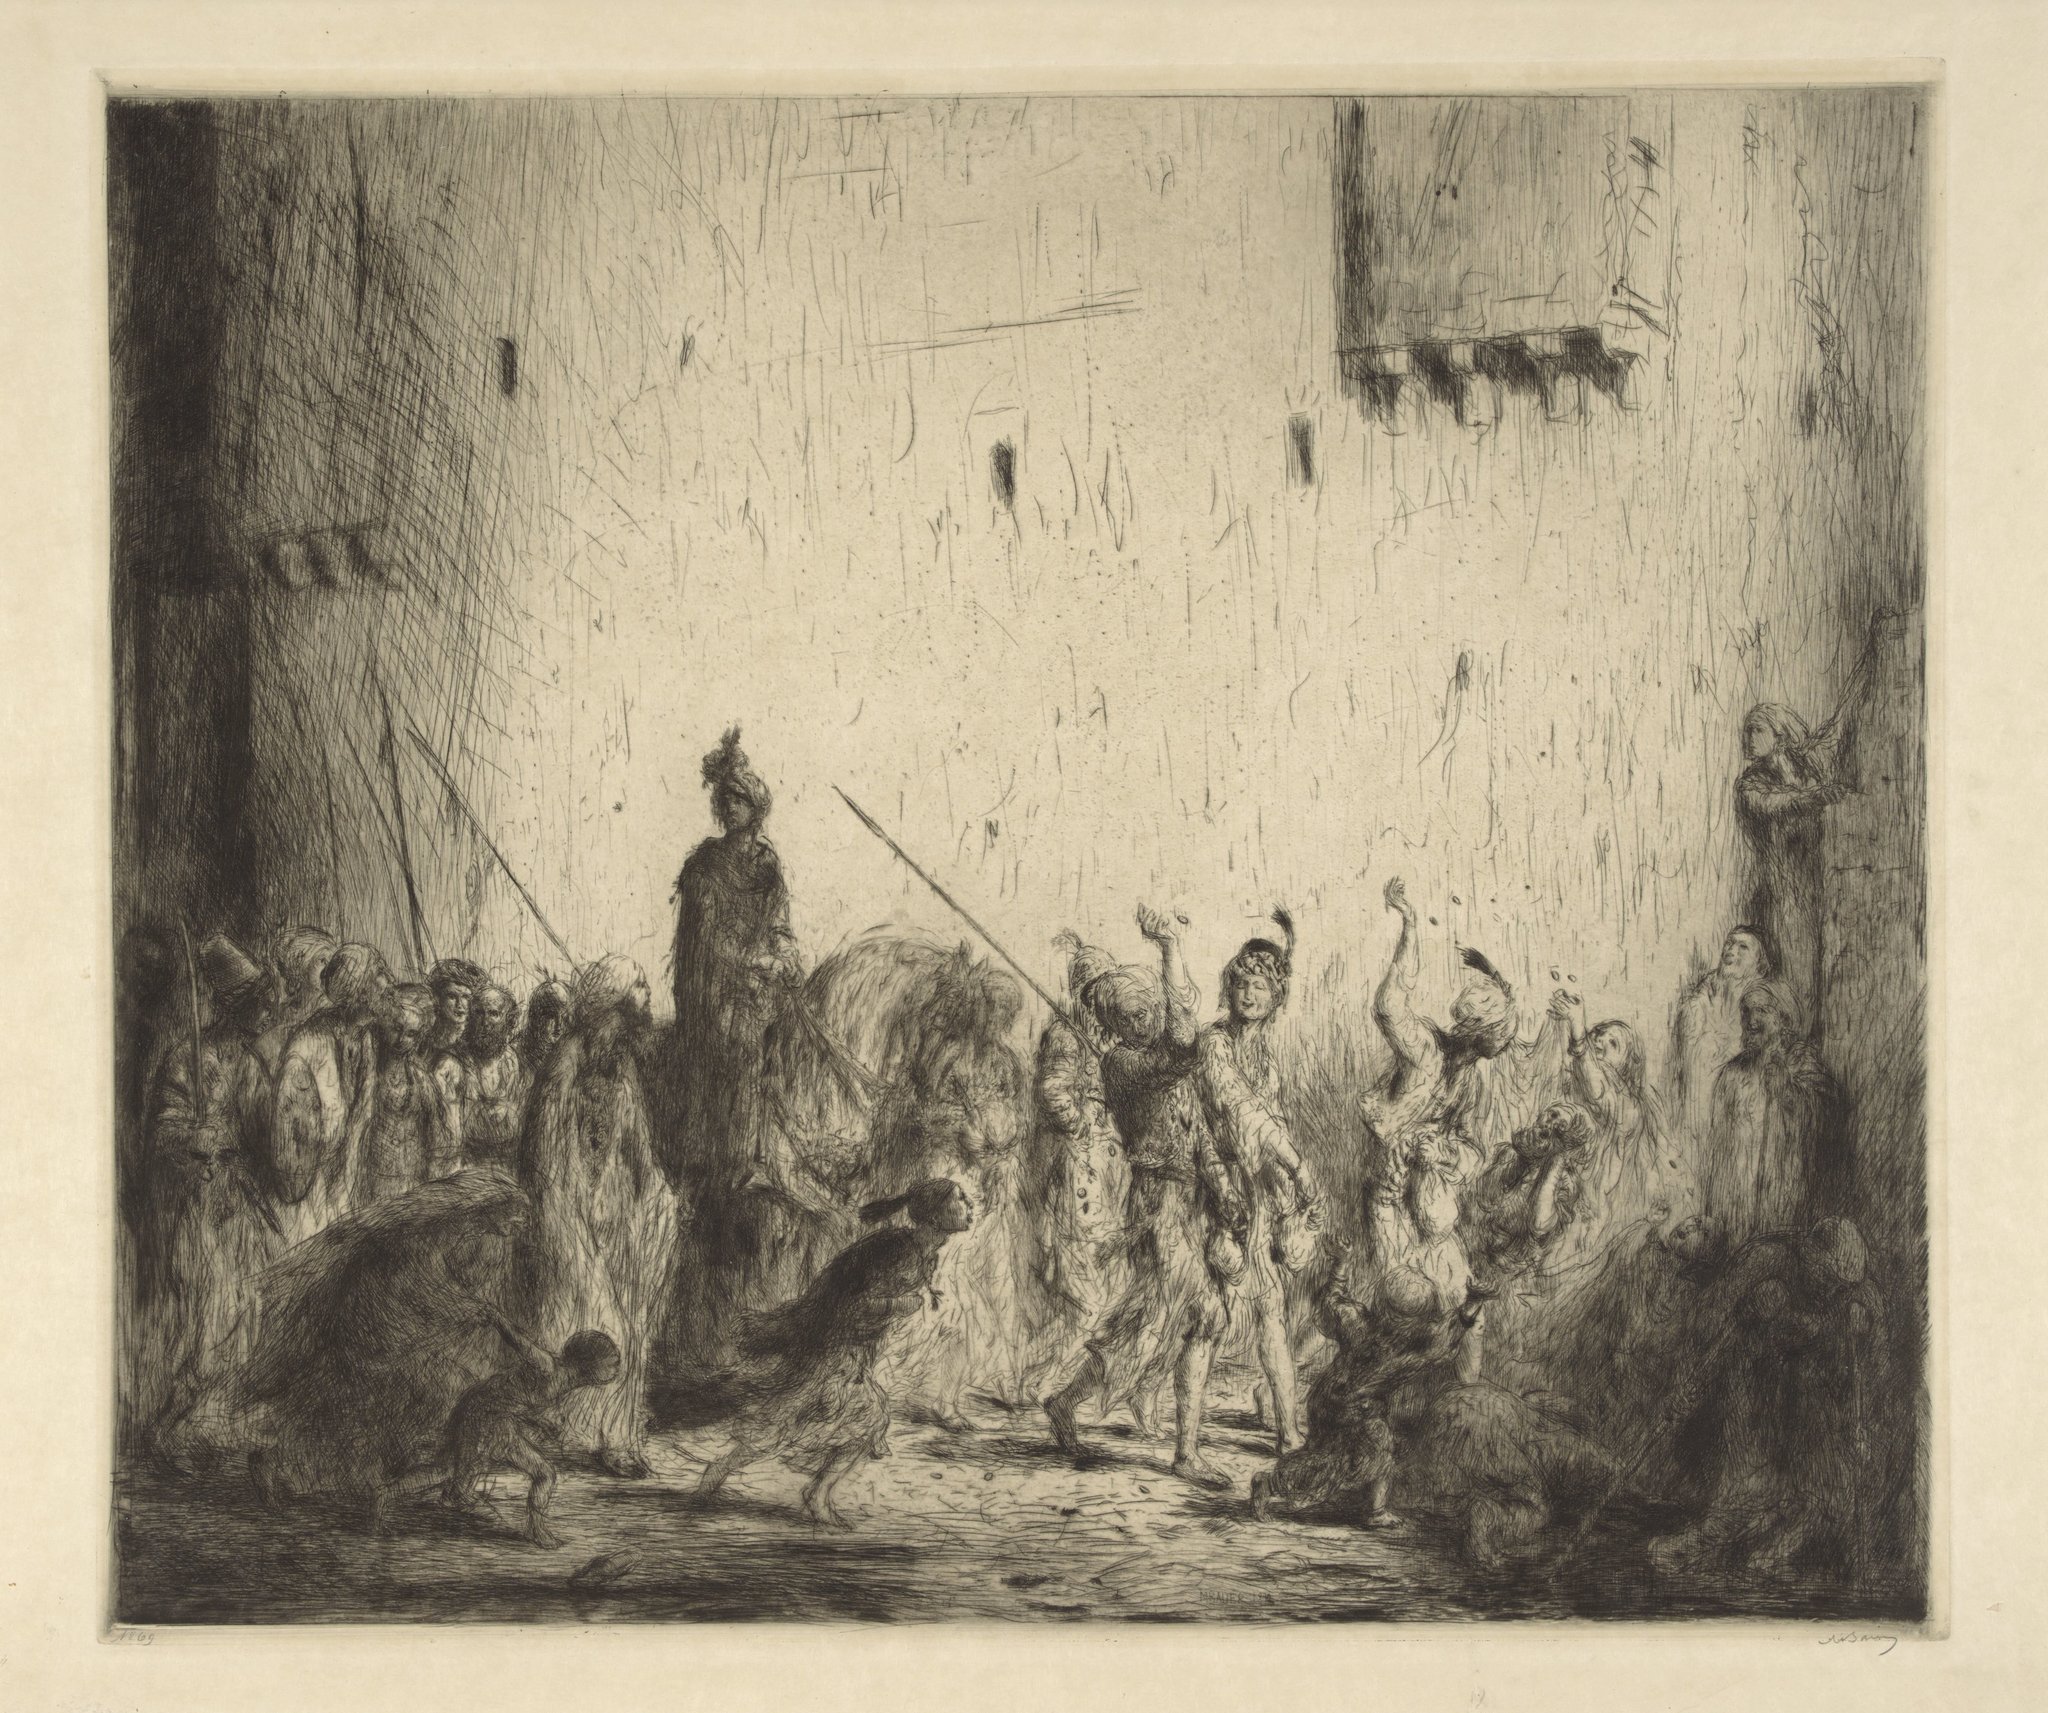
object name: print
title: Prins te paard rijdt door een stad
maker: marius bauer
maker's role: draughtsman, print maker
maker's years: 1867-1932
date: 1912-1913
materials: paper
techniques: etching, intaglio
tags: riding a horse, ass, or mule; rider, horseman, crowd, mob, street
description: De prins rijdt door een menigte mensen. Rechts een dansende groep.